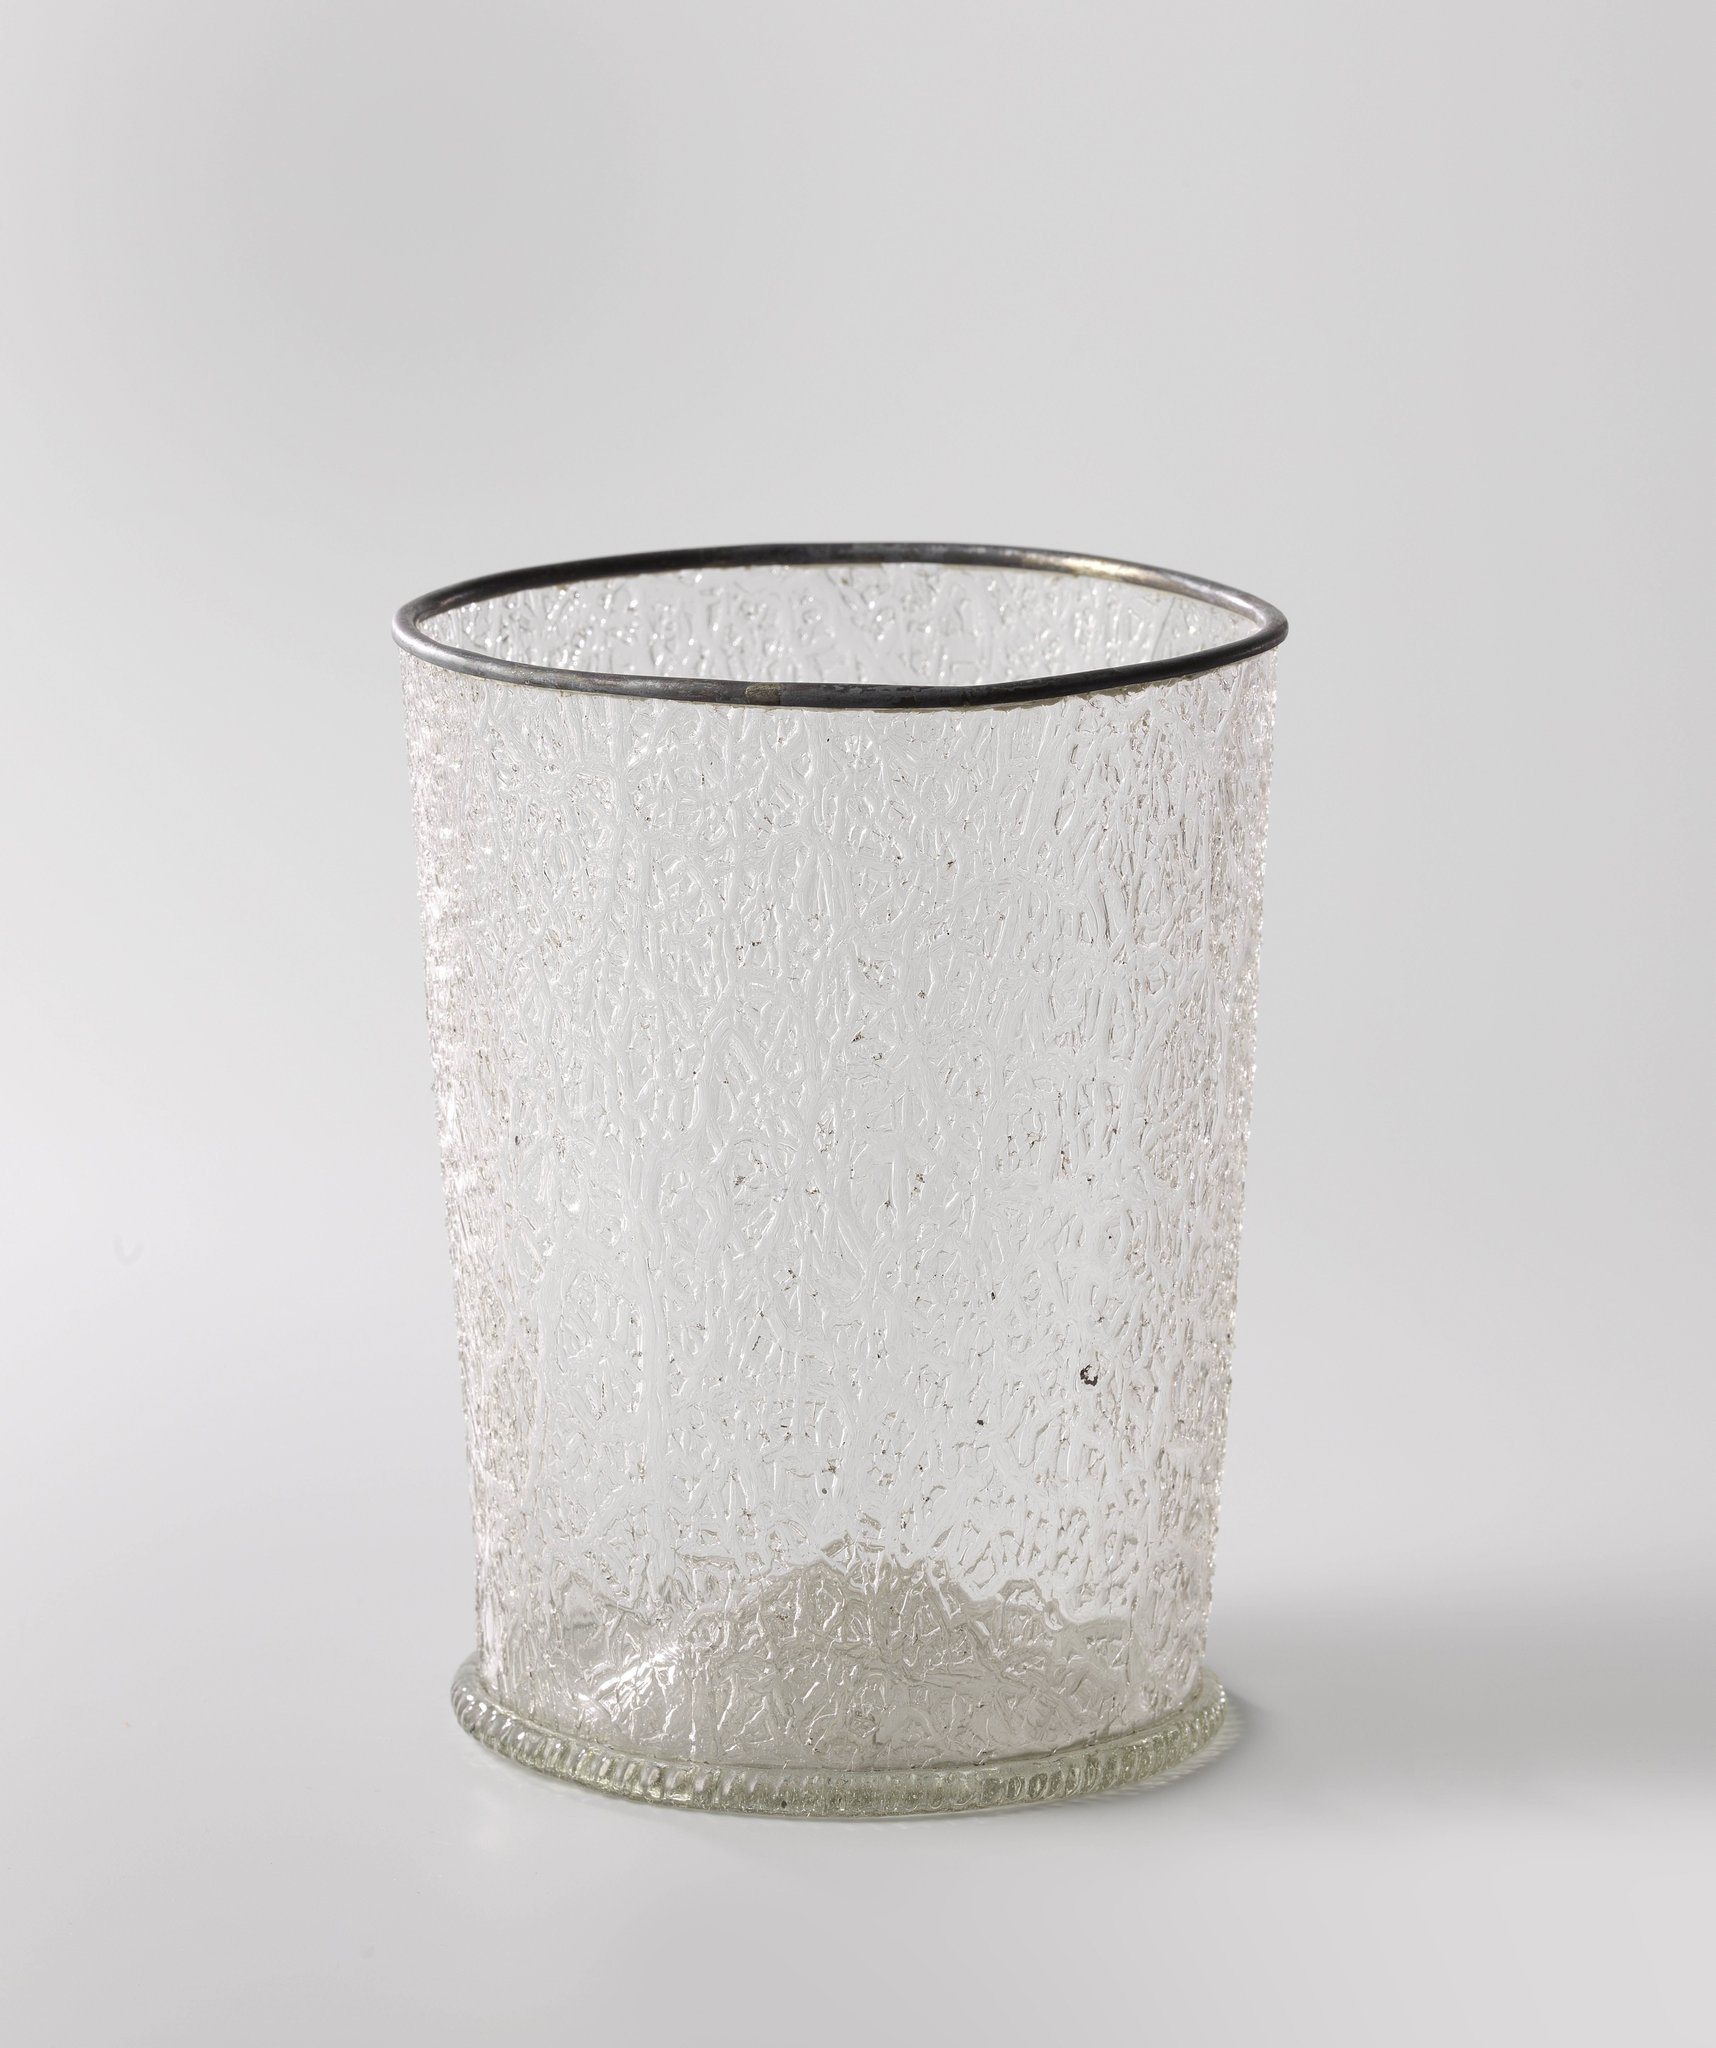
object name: cup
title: Beker van ijsglas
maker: Anonymous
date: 1550-1650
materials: glass, silver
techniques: façon de venise, glassblowing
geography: low countries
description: Beker van ijsglas, met ingestoken bodem. Geribde standring van helder glas. Bekervormig lichaam. Langs de bovenrand een zilveren montuur.